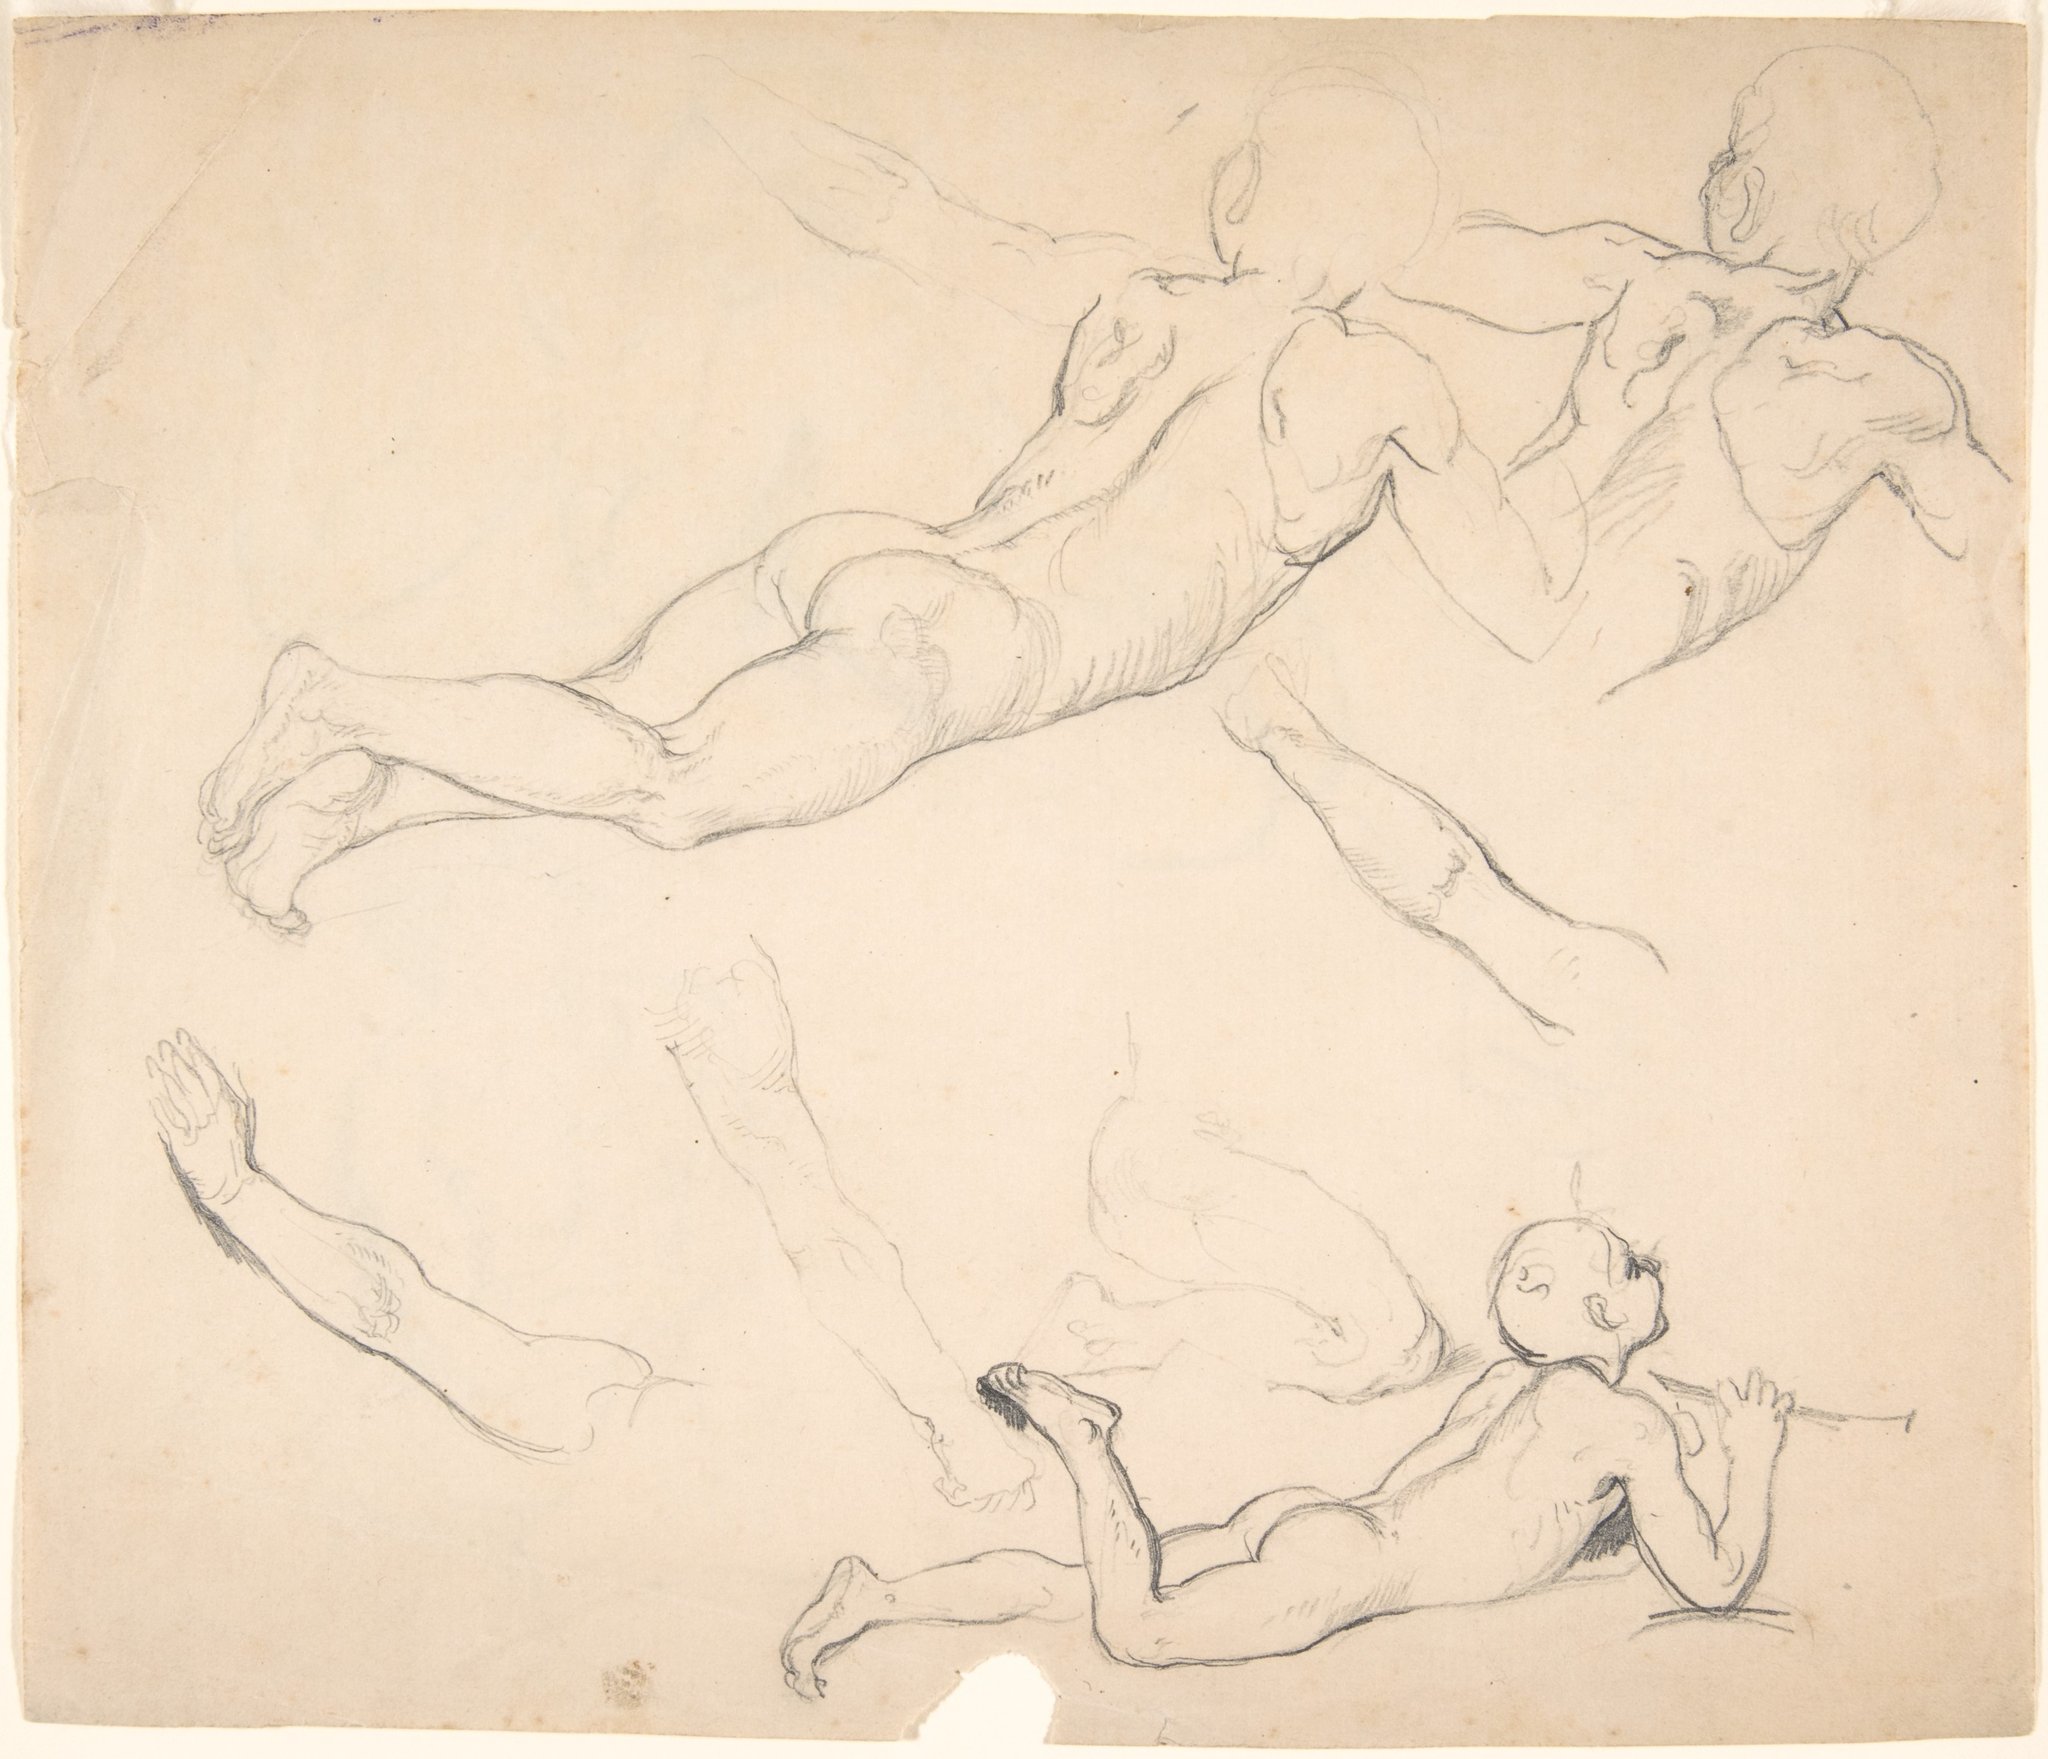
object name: drawing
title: Studies of a Boy Playing the Flute; verso: Studies of Seated Man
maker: eduard julius friedrich bendemann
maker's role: artist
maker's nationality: german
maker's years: 1811-1889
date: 1811-1889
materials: graphite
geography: germany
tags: boys,male nudes,flutes,musicians